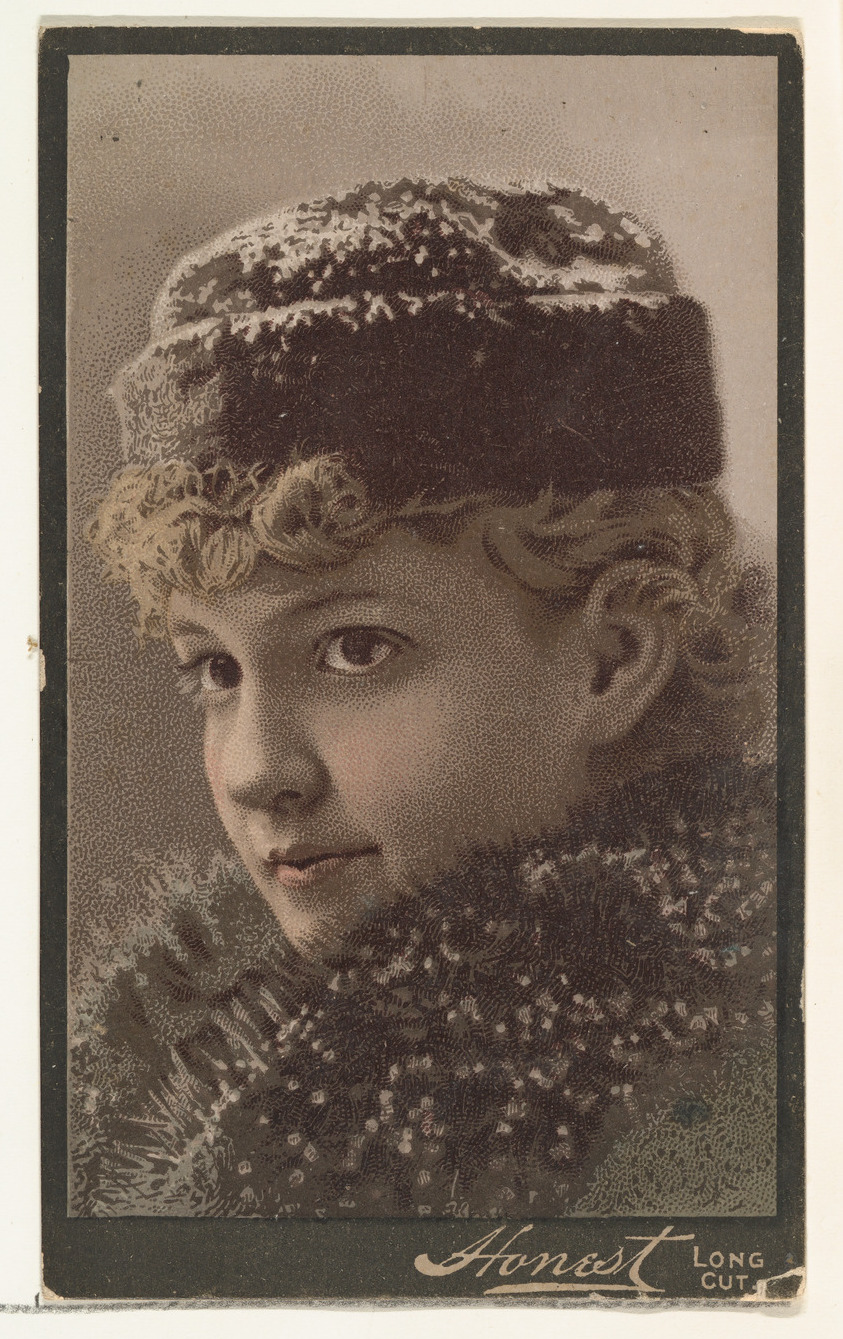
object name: print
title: Actress wearing fur collar and hat, from Stars of the Stage, Third Series (N131) issued by Duke Sons & Co. to promote Honest Long Cut Tobacco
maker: w. duke, sons & co.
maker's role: publisher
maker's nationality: american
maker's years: 1870-1920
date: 1891-1892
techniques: color lithograph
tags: portraits,women,actresses